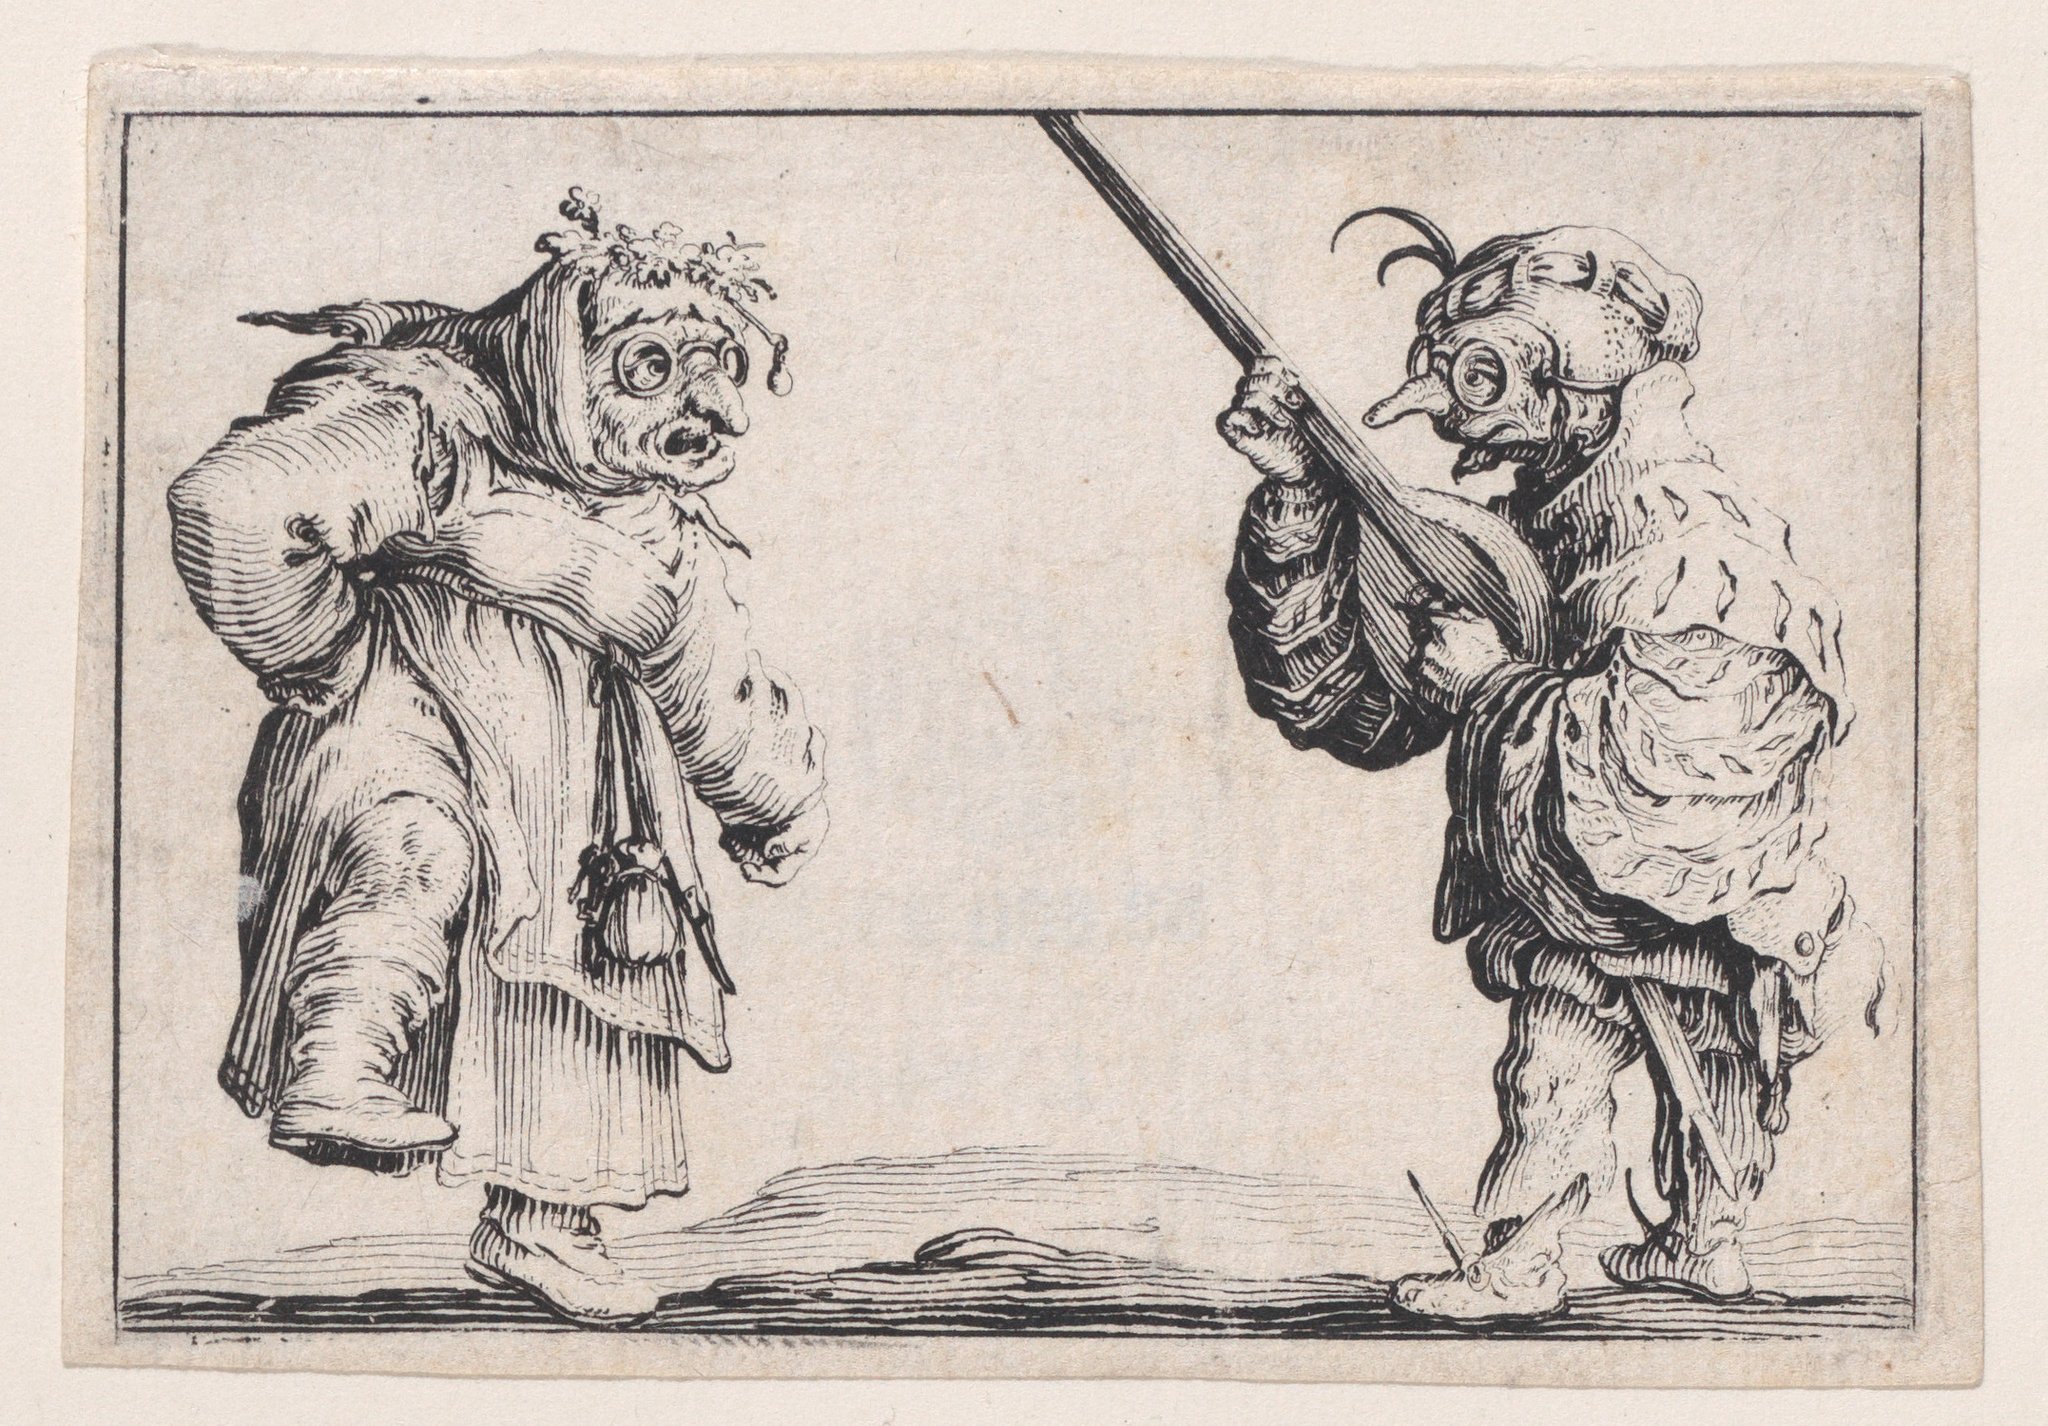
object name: print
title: Les Danseurs Au Luth (The Dancers with a Lute), from Les Caprices Series A, The Florence Set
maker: jacques callot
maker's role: artist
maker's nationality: french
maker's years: 1592-1635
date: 1617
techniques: etching